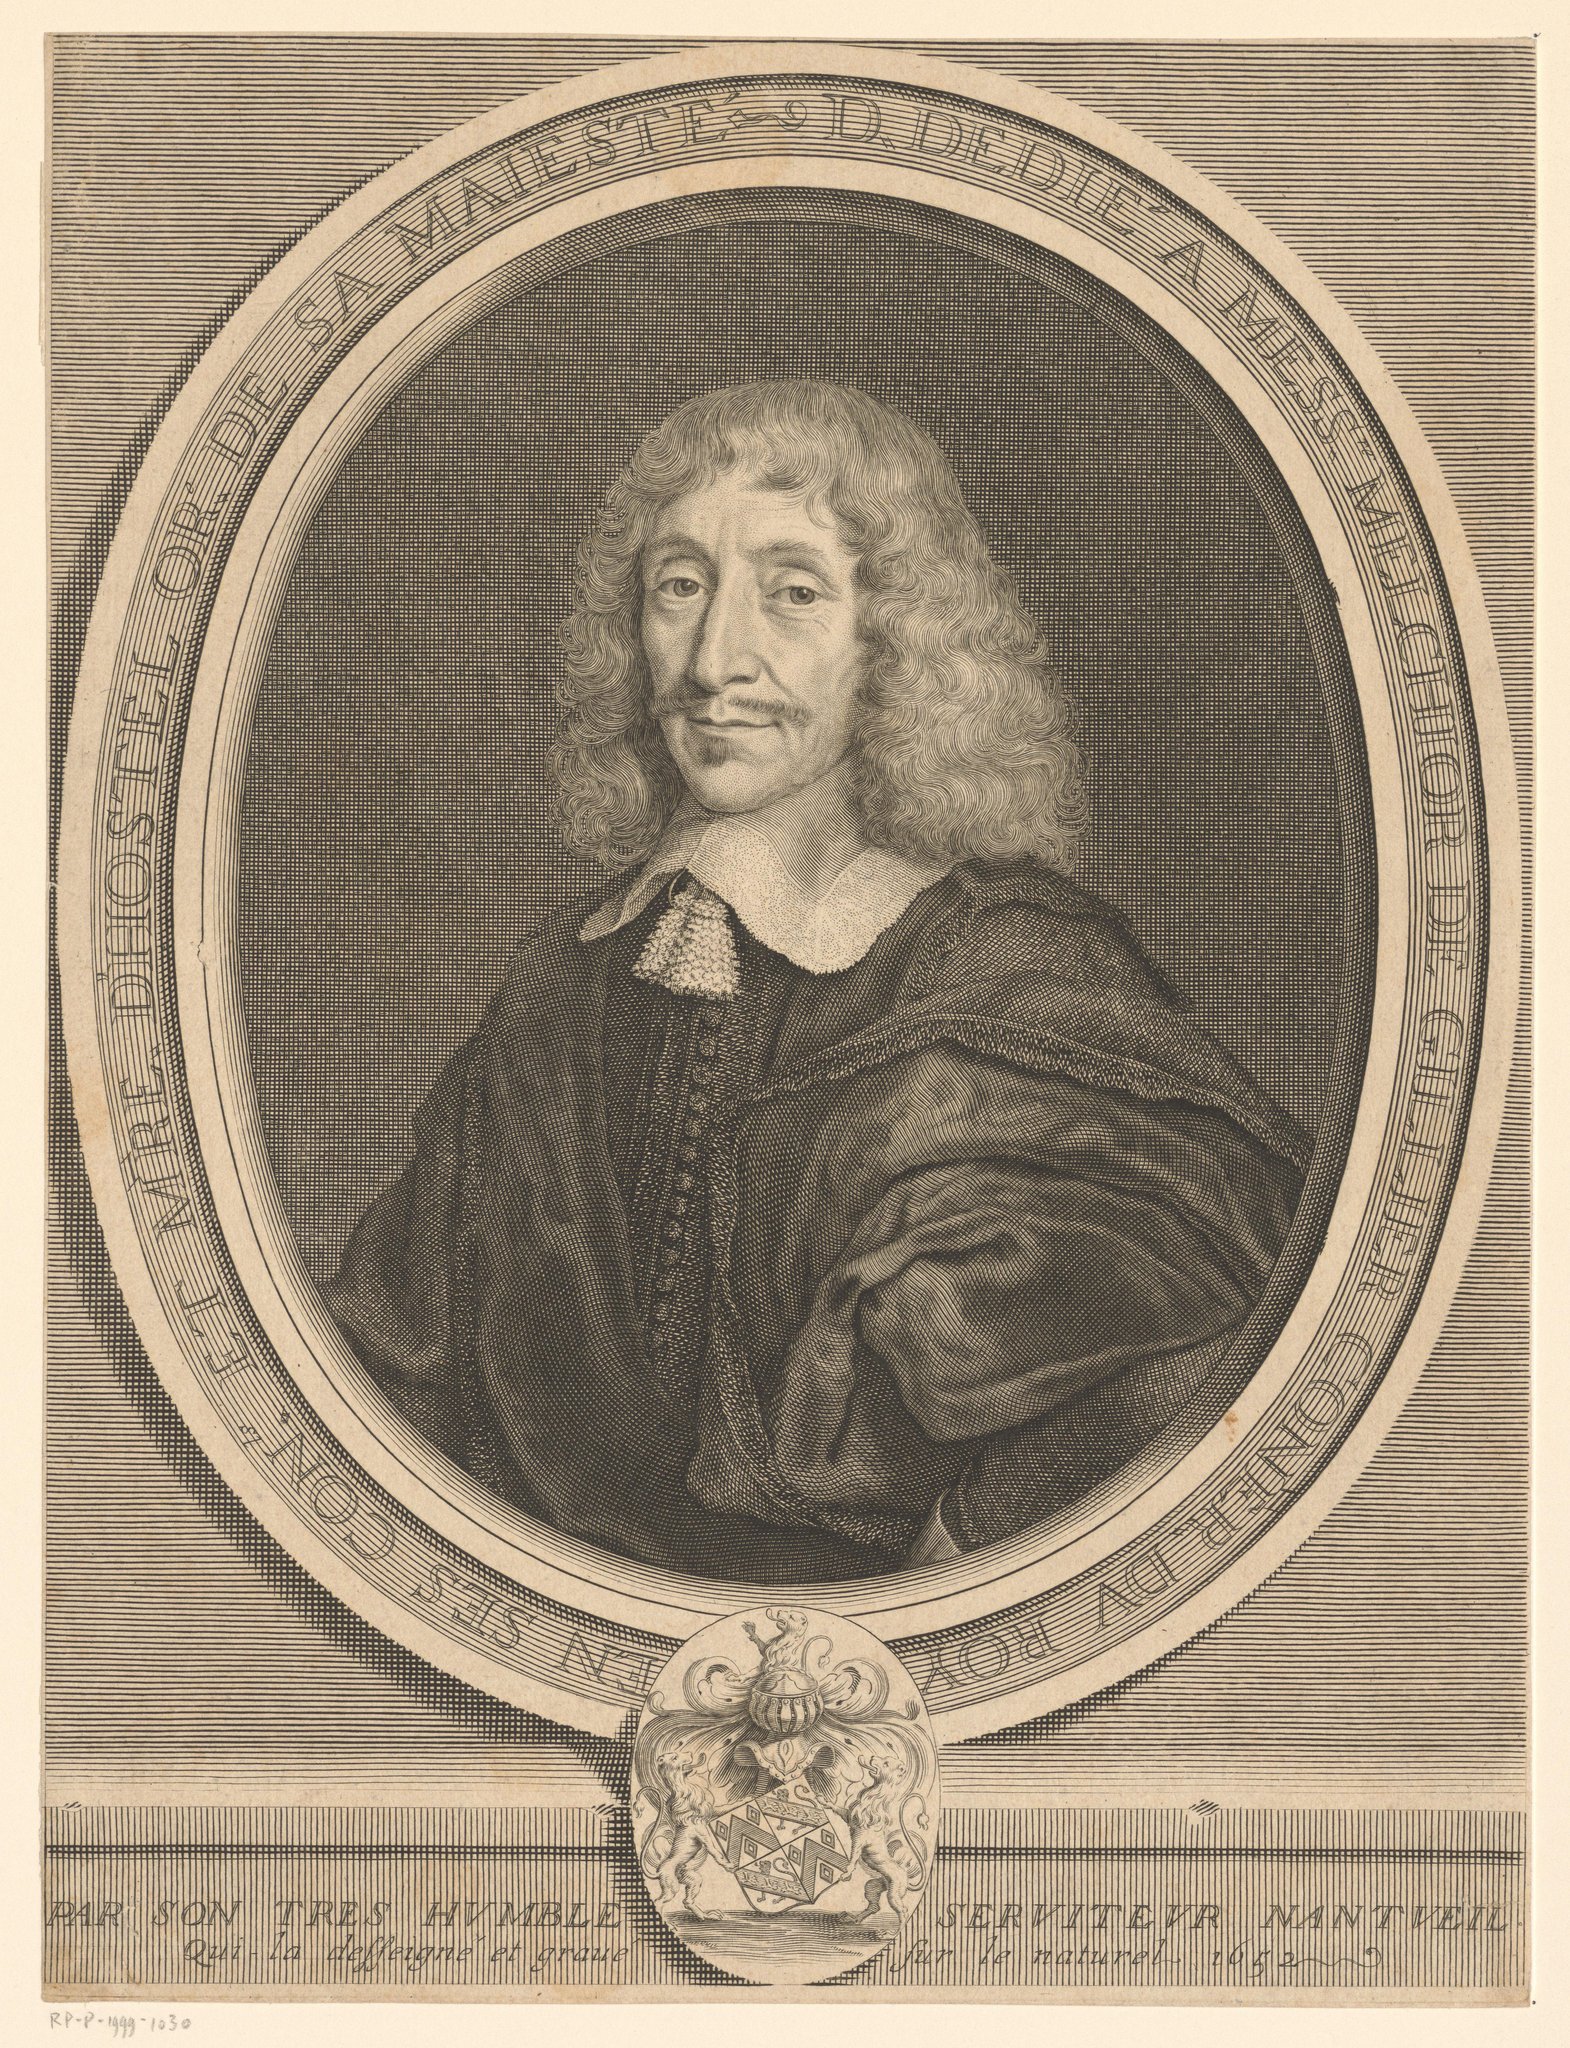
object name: print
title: Portret van Melchior de Gillier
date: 1652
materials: paper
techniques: engraving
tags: melchior de gillier, historical persons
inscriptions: collector's mark: Lugt 2228, collector's mark: Lugt 1482b, collector's mark: Lugt 2760